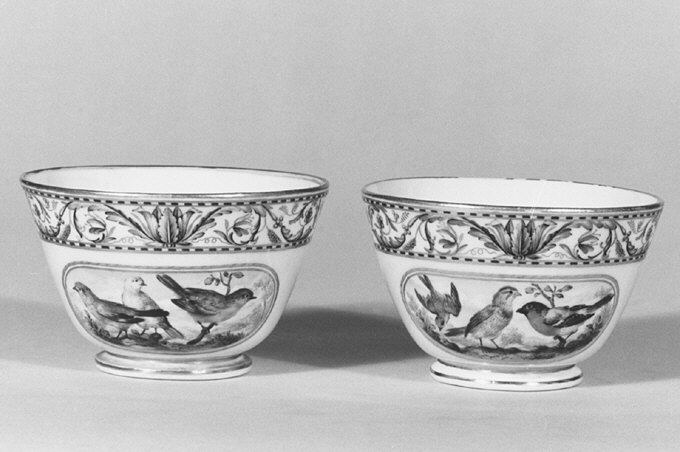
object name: saucer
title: Saucer (part of a service)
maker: meissen manufactory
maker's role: manufactory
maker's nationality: german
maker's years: 1710-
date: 1780-1785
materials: hard paste porcelain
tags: birds